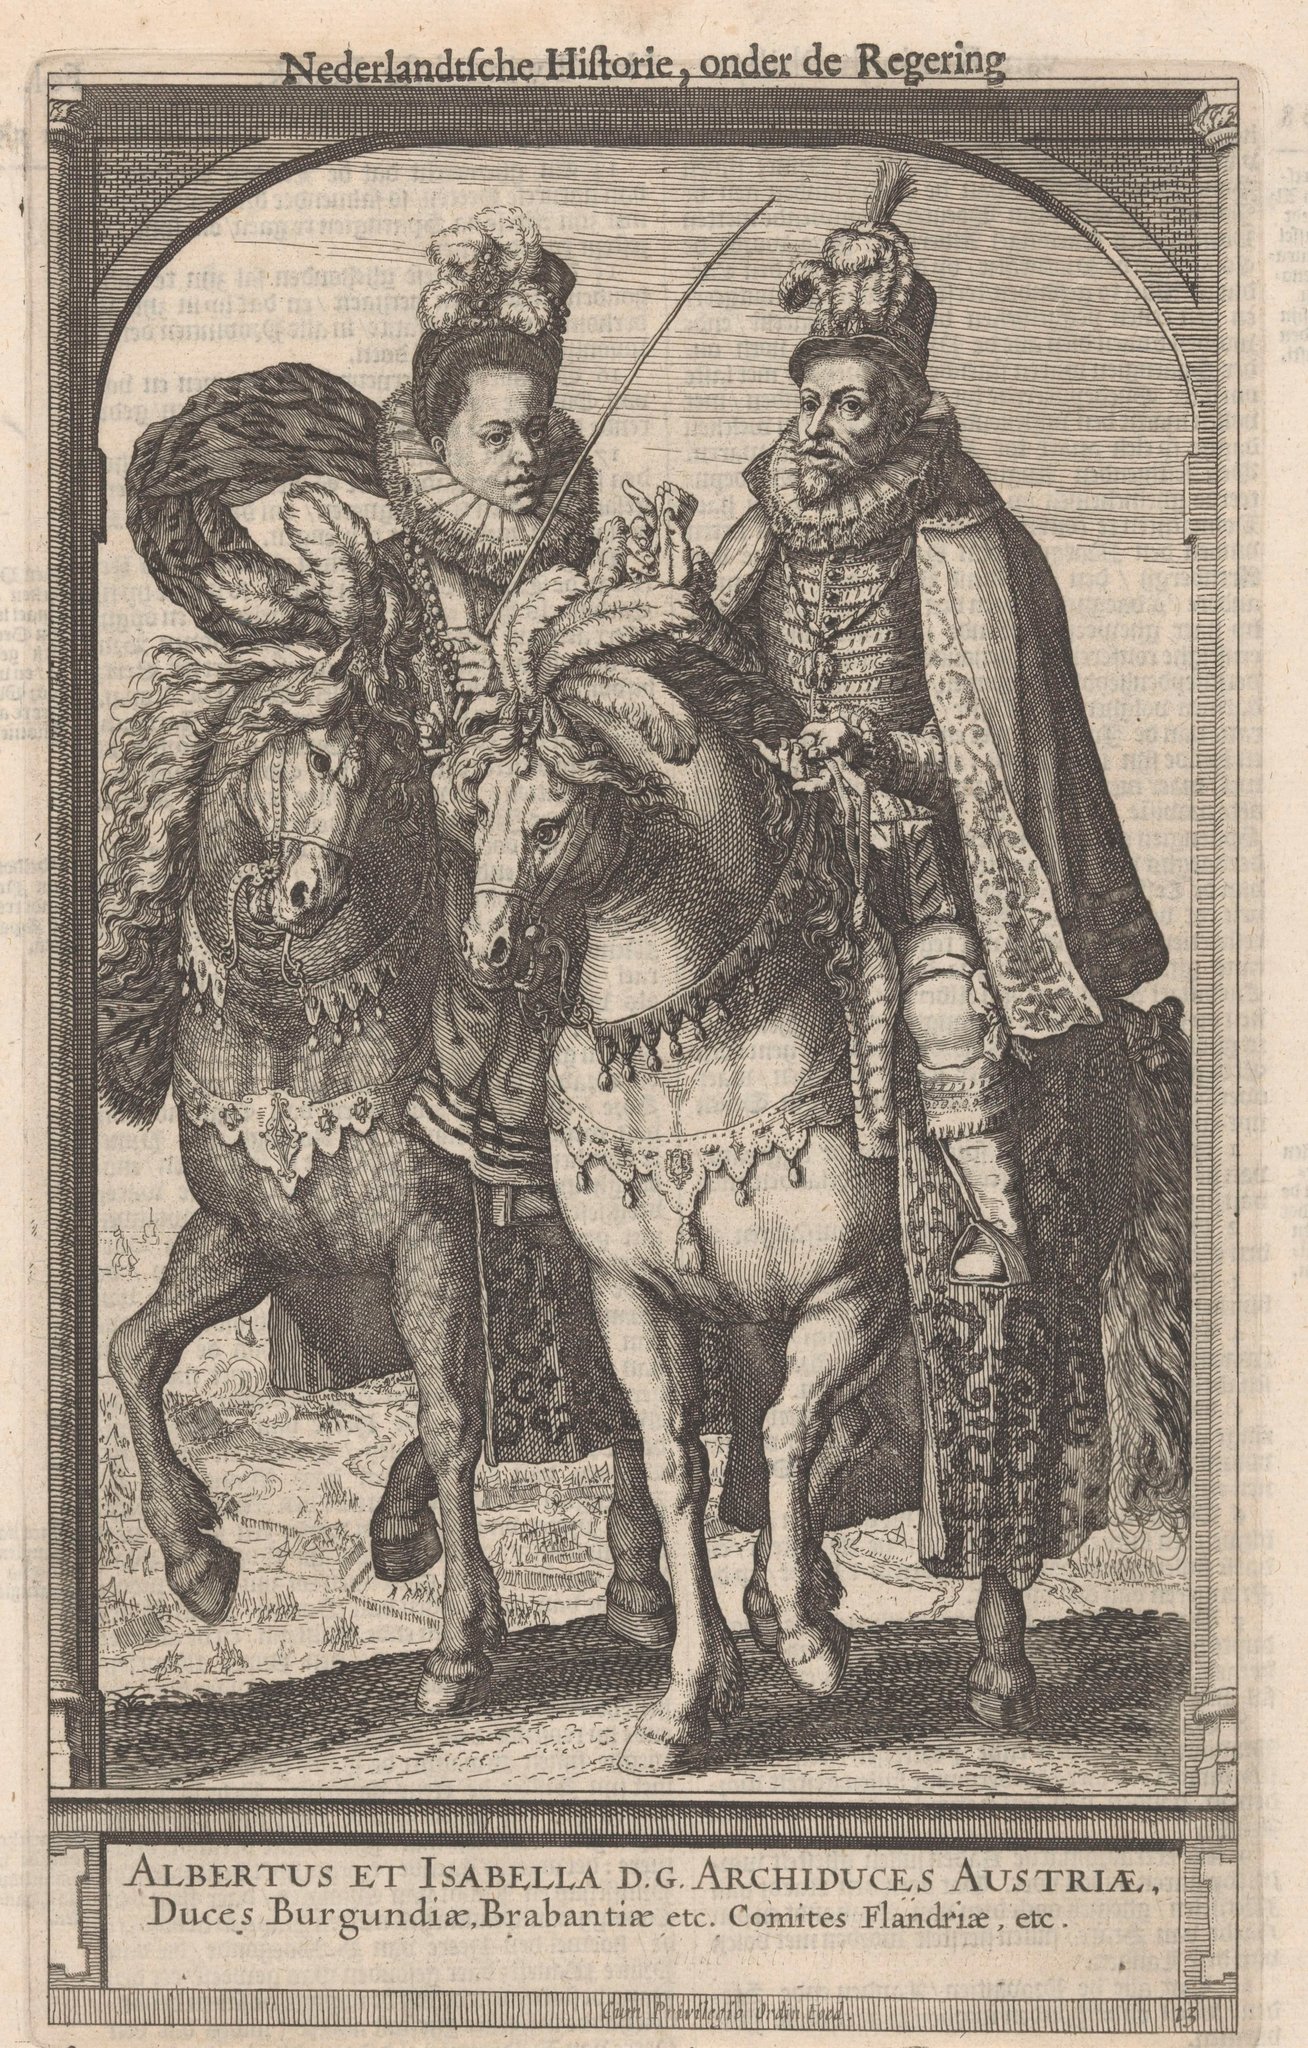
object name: print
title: Ruiterportret van Albrecht, aartshertog van Oostenrijk, en Isabella Clara Eugenia, infante van Spanje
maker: Anonymous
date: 1600-1699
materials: paper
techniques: etching, letterpress printing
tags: infante van spanje isabella clara eugenia, brussels, albrecht aartshertog van oostenrijk, knighthood order of the golden fleece - insignia of a knighthood order, e.g.: badge, chain (with name of order)